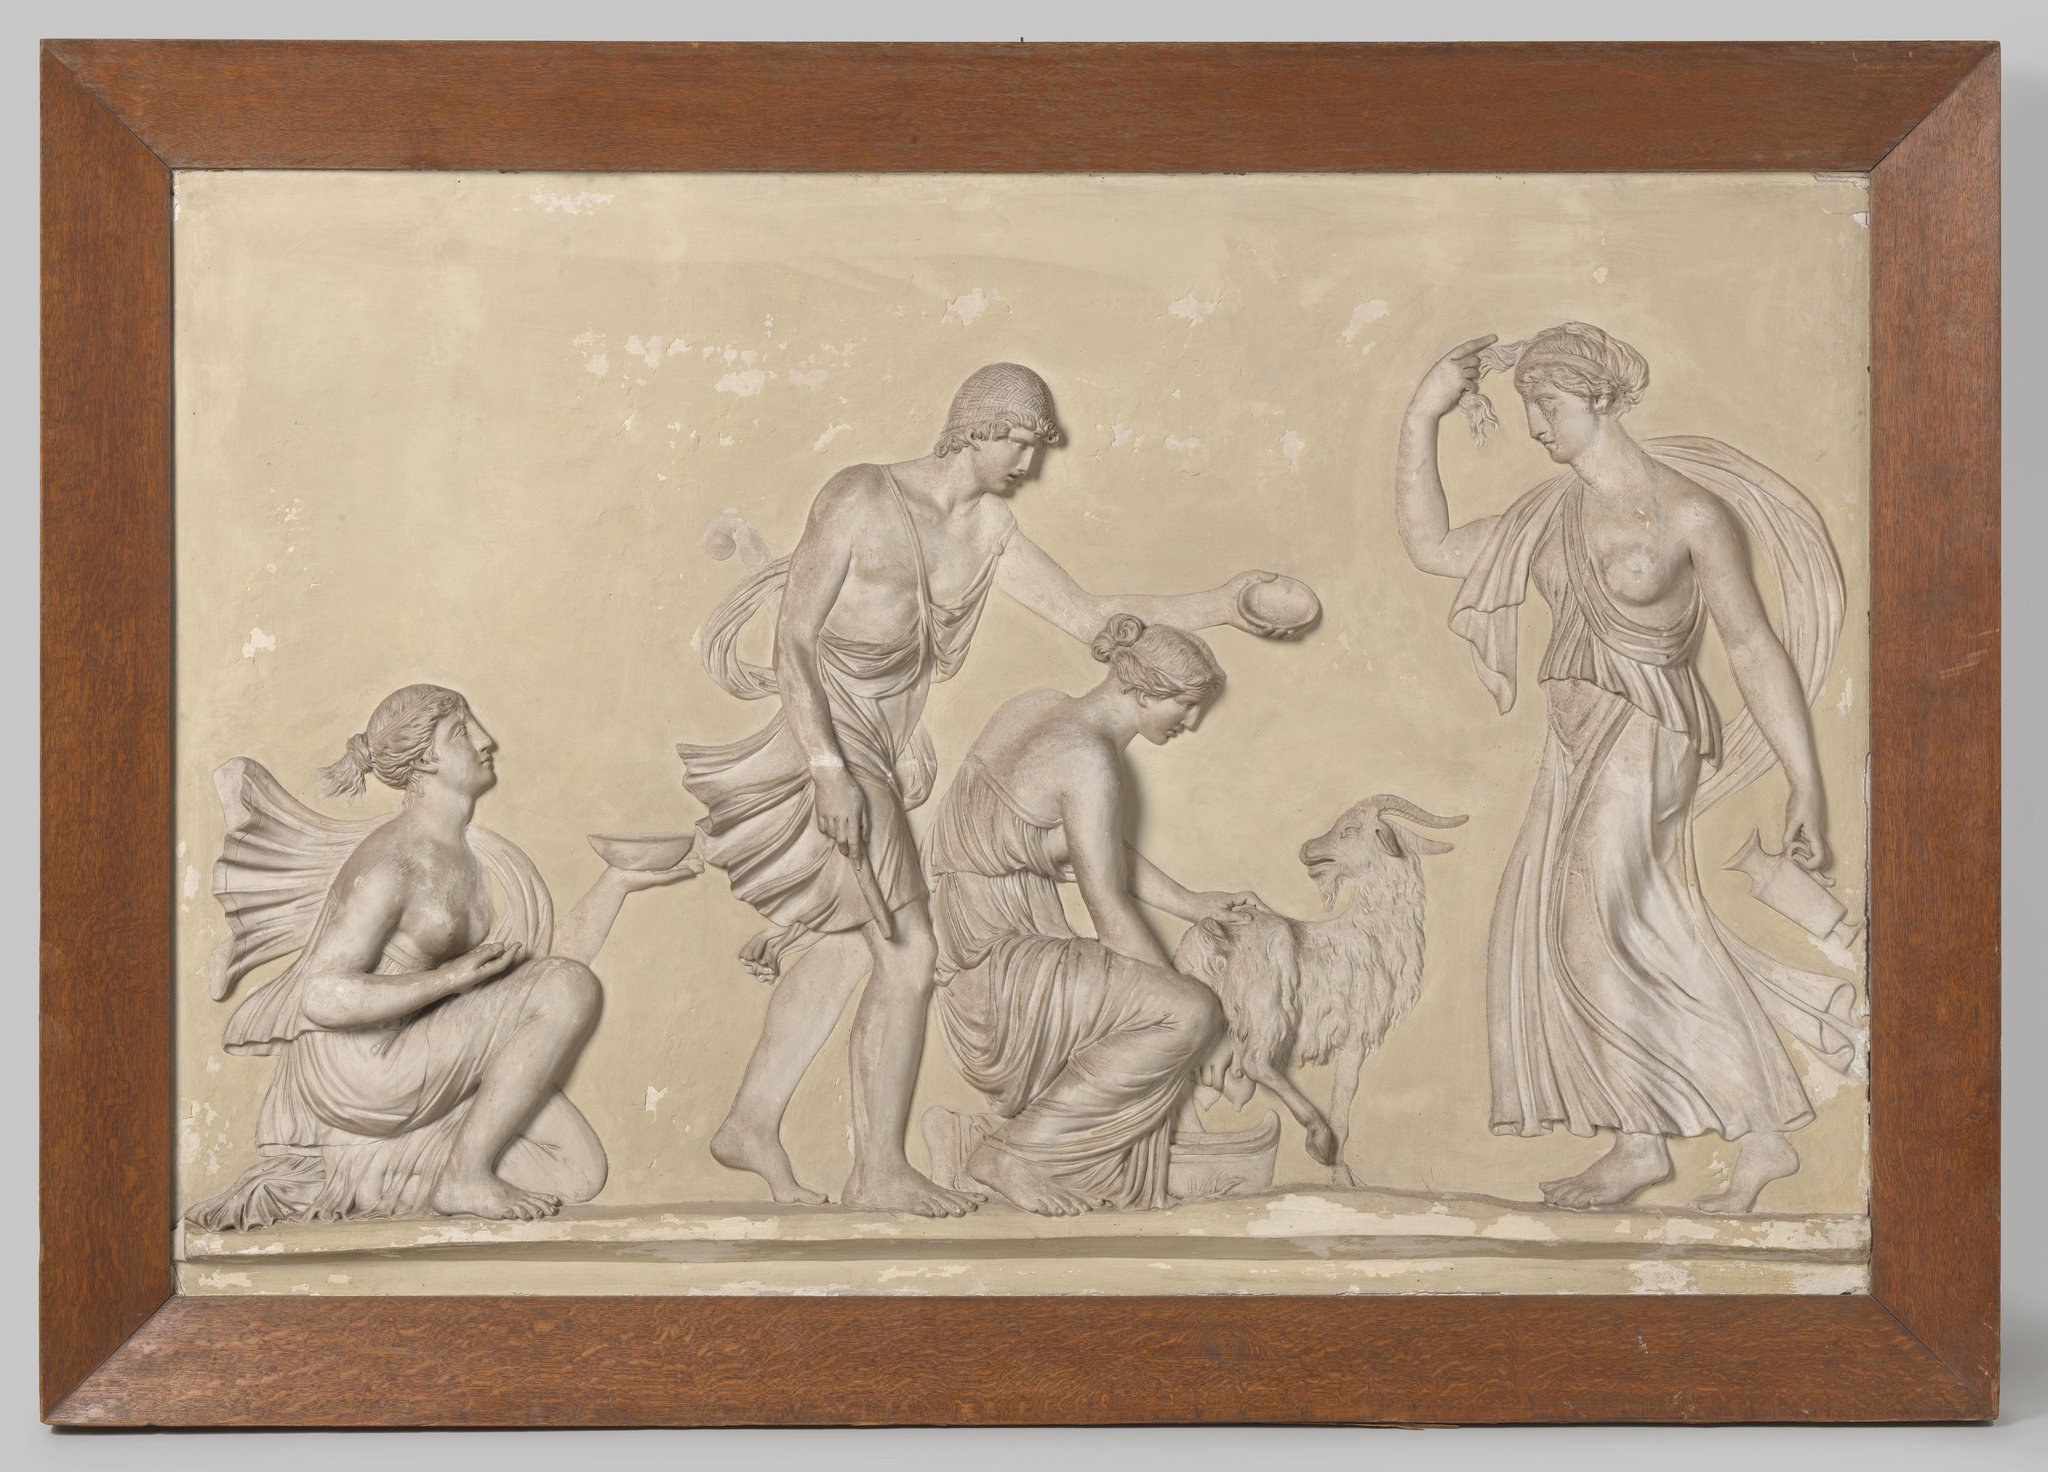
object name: relief sculpture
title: Dessus-de-porte van gips met voorstelling van een knielende vrouw die een geit melkt. In eikenhouten omlijsting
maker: Anonymous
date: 1780-1825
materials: gypsum, wood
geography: france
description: Dessus-de-porte of bovendeurstuk van gips in een moderne eikenhouten omlijsting. In reliëf is in het midden een knielende vrouw weergegeven, die bezig is met het melken van een geit. Links een staande man en knielende vrouw met kommetjes; rechts een naderende vrouw met kan. Zie tevens: BK-1957-33-a en c/d.